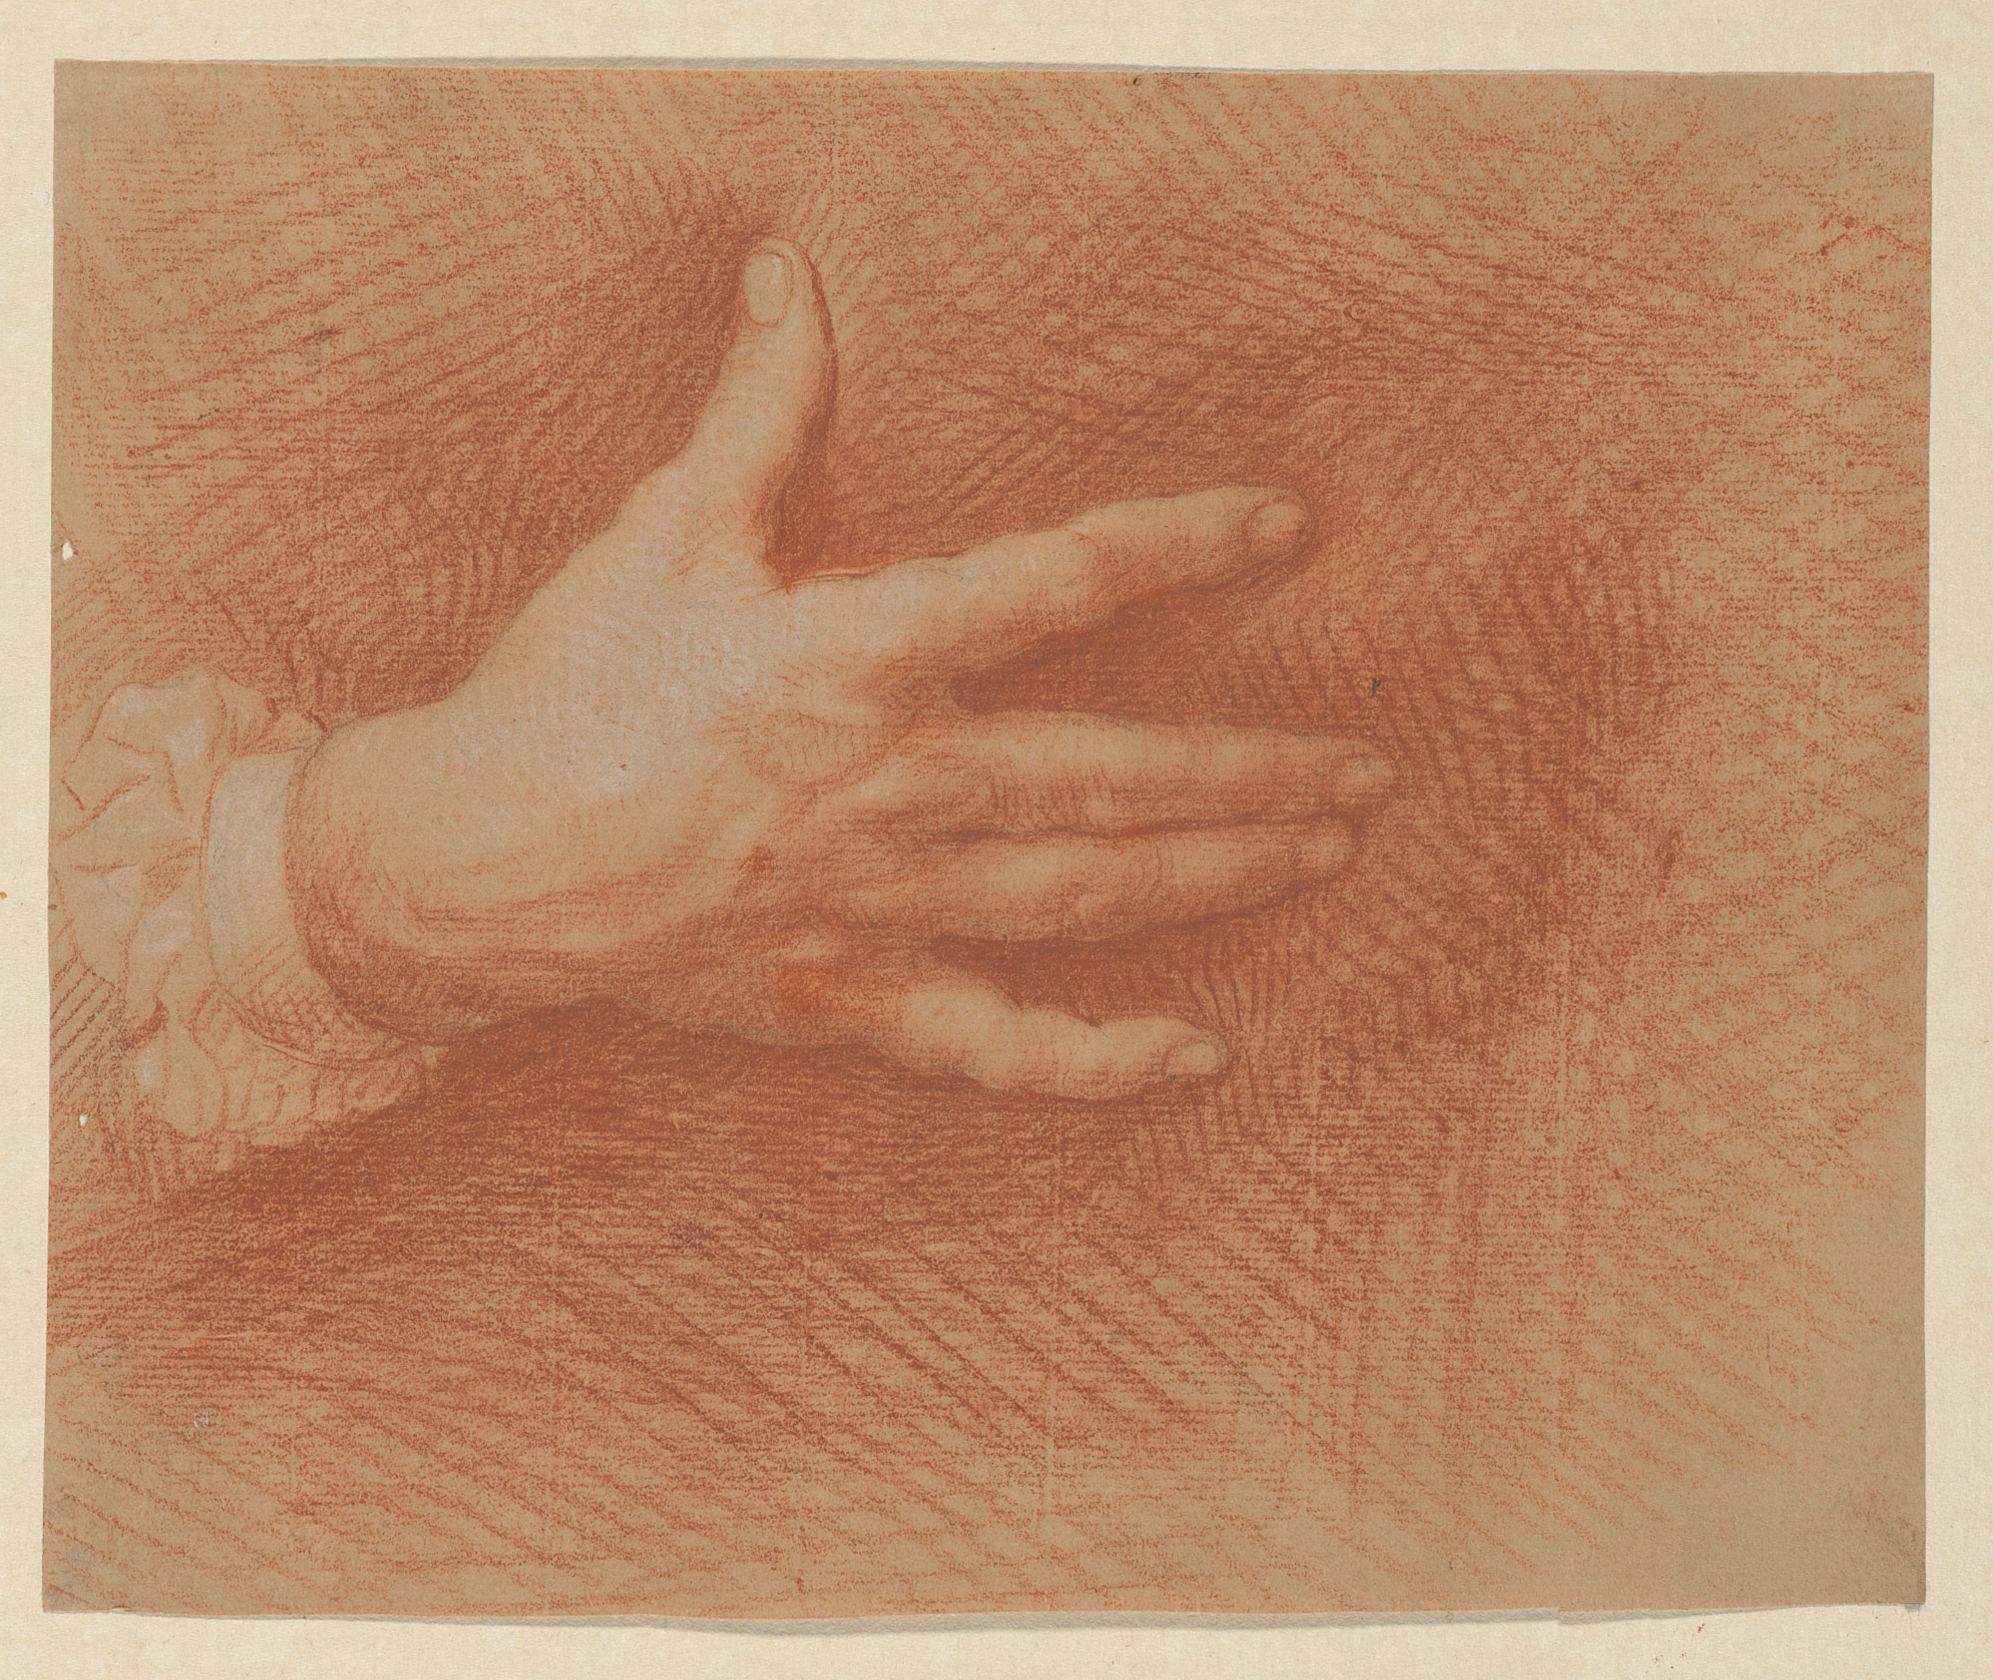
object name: drawing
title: Studie van een hand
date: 1649-1723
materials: chalk, paper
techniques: pasting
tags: postures and gestures of arms and hands